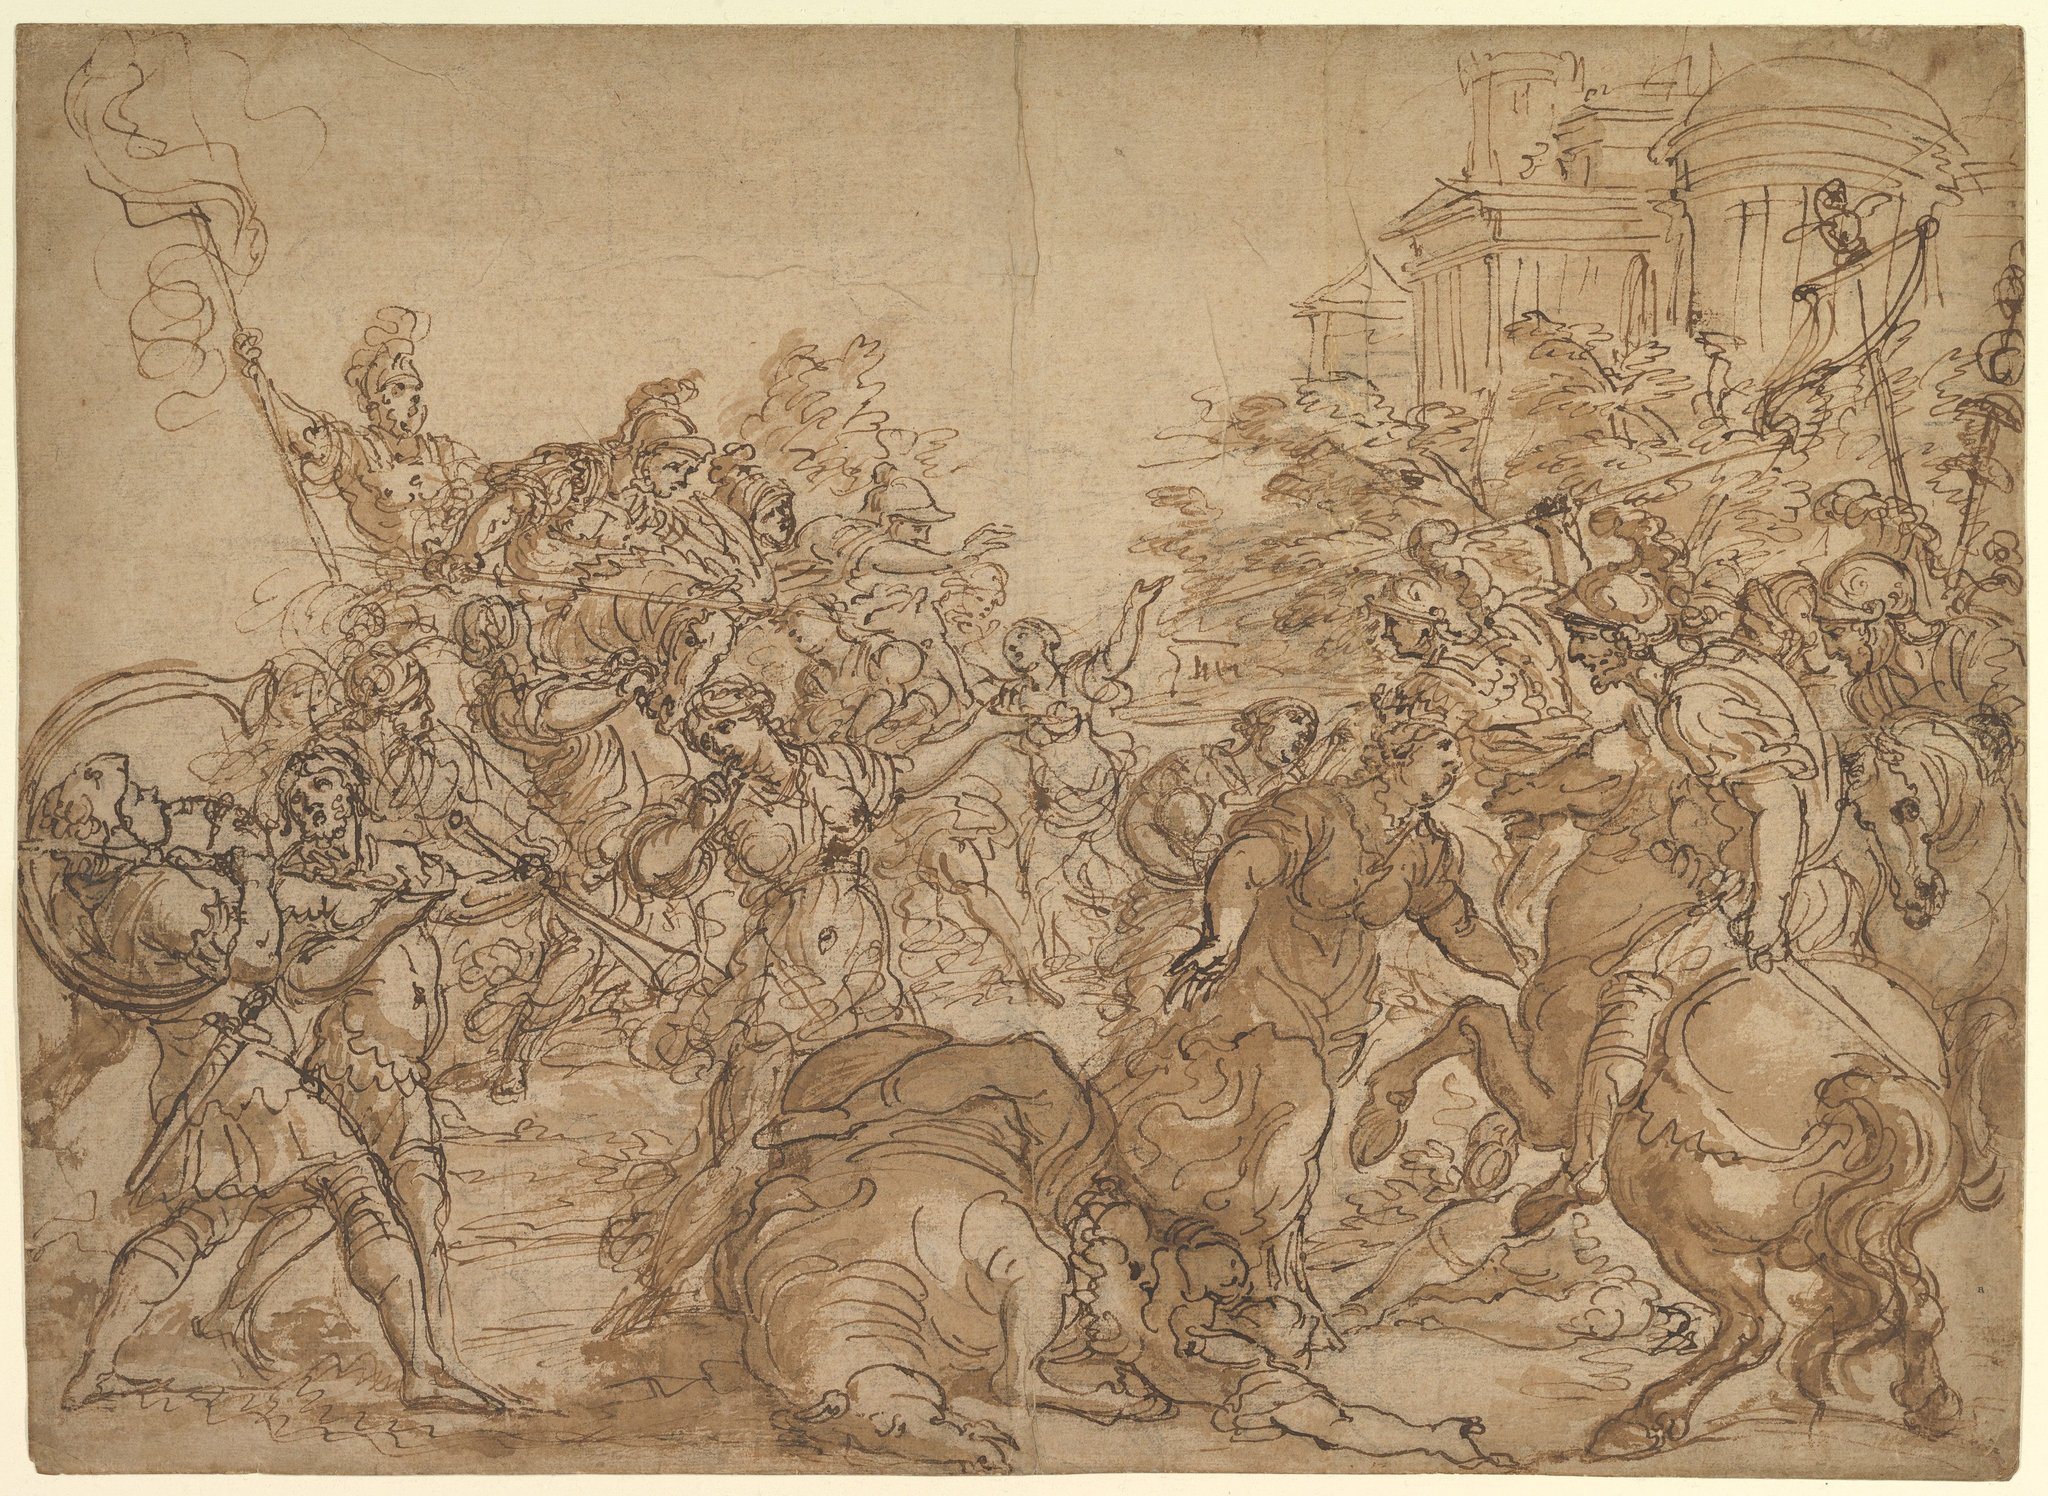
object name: drawing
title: The Sabine Women Pleading for Peace.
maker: giovanni battista foggini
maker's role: artist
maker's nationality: italian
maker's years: 1652-1725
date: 1652-1725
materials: chalk, ink, paper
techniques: brush, pen, wash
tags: buildings,battles,men,women,horses